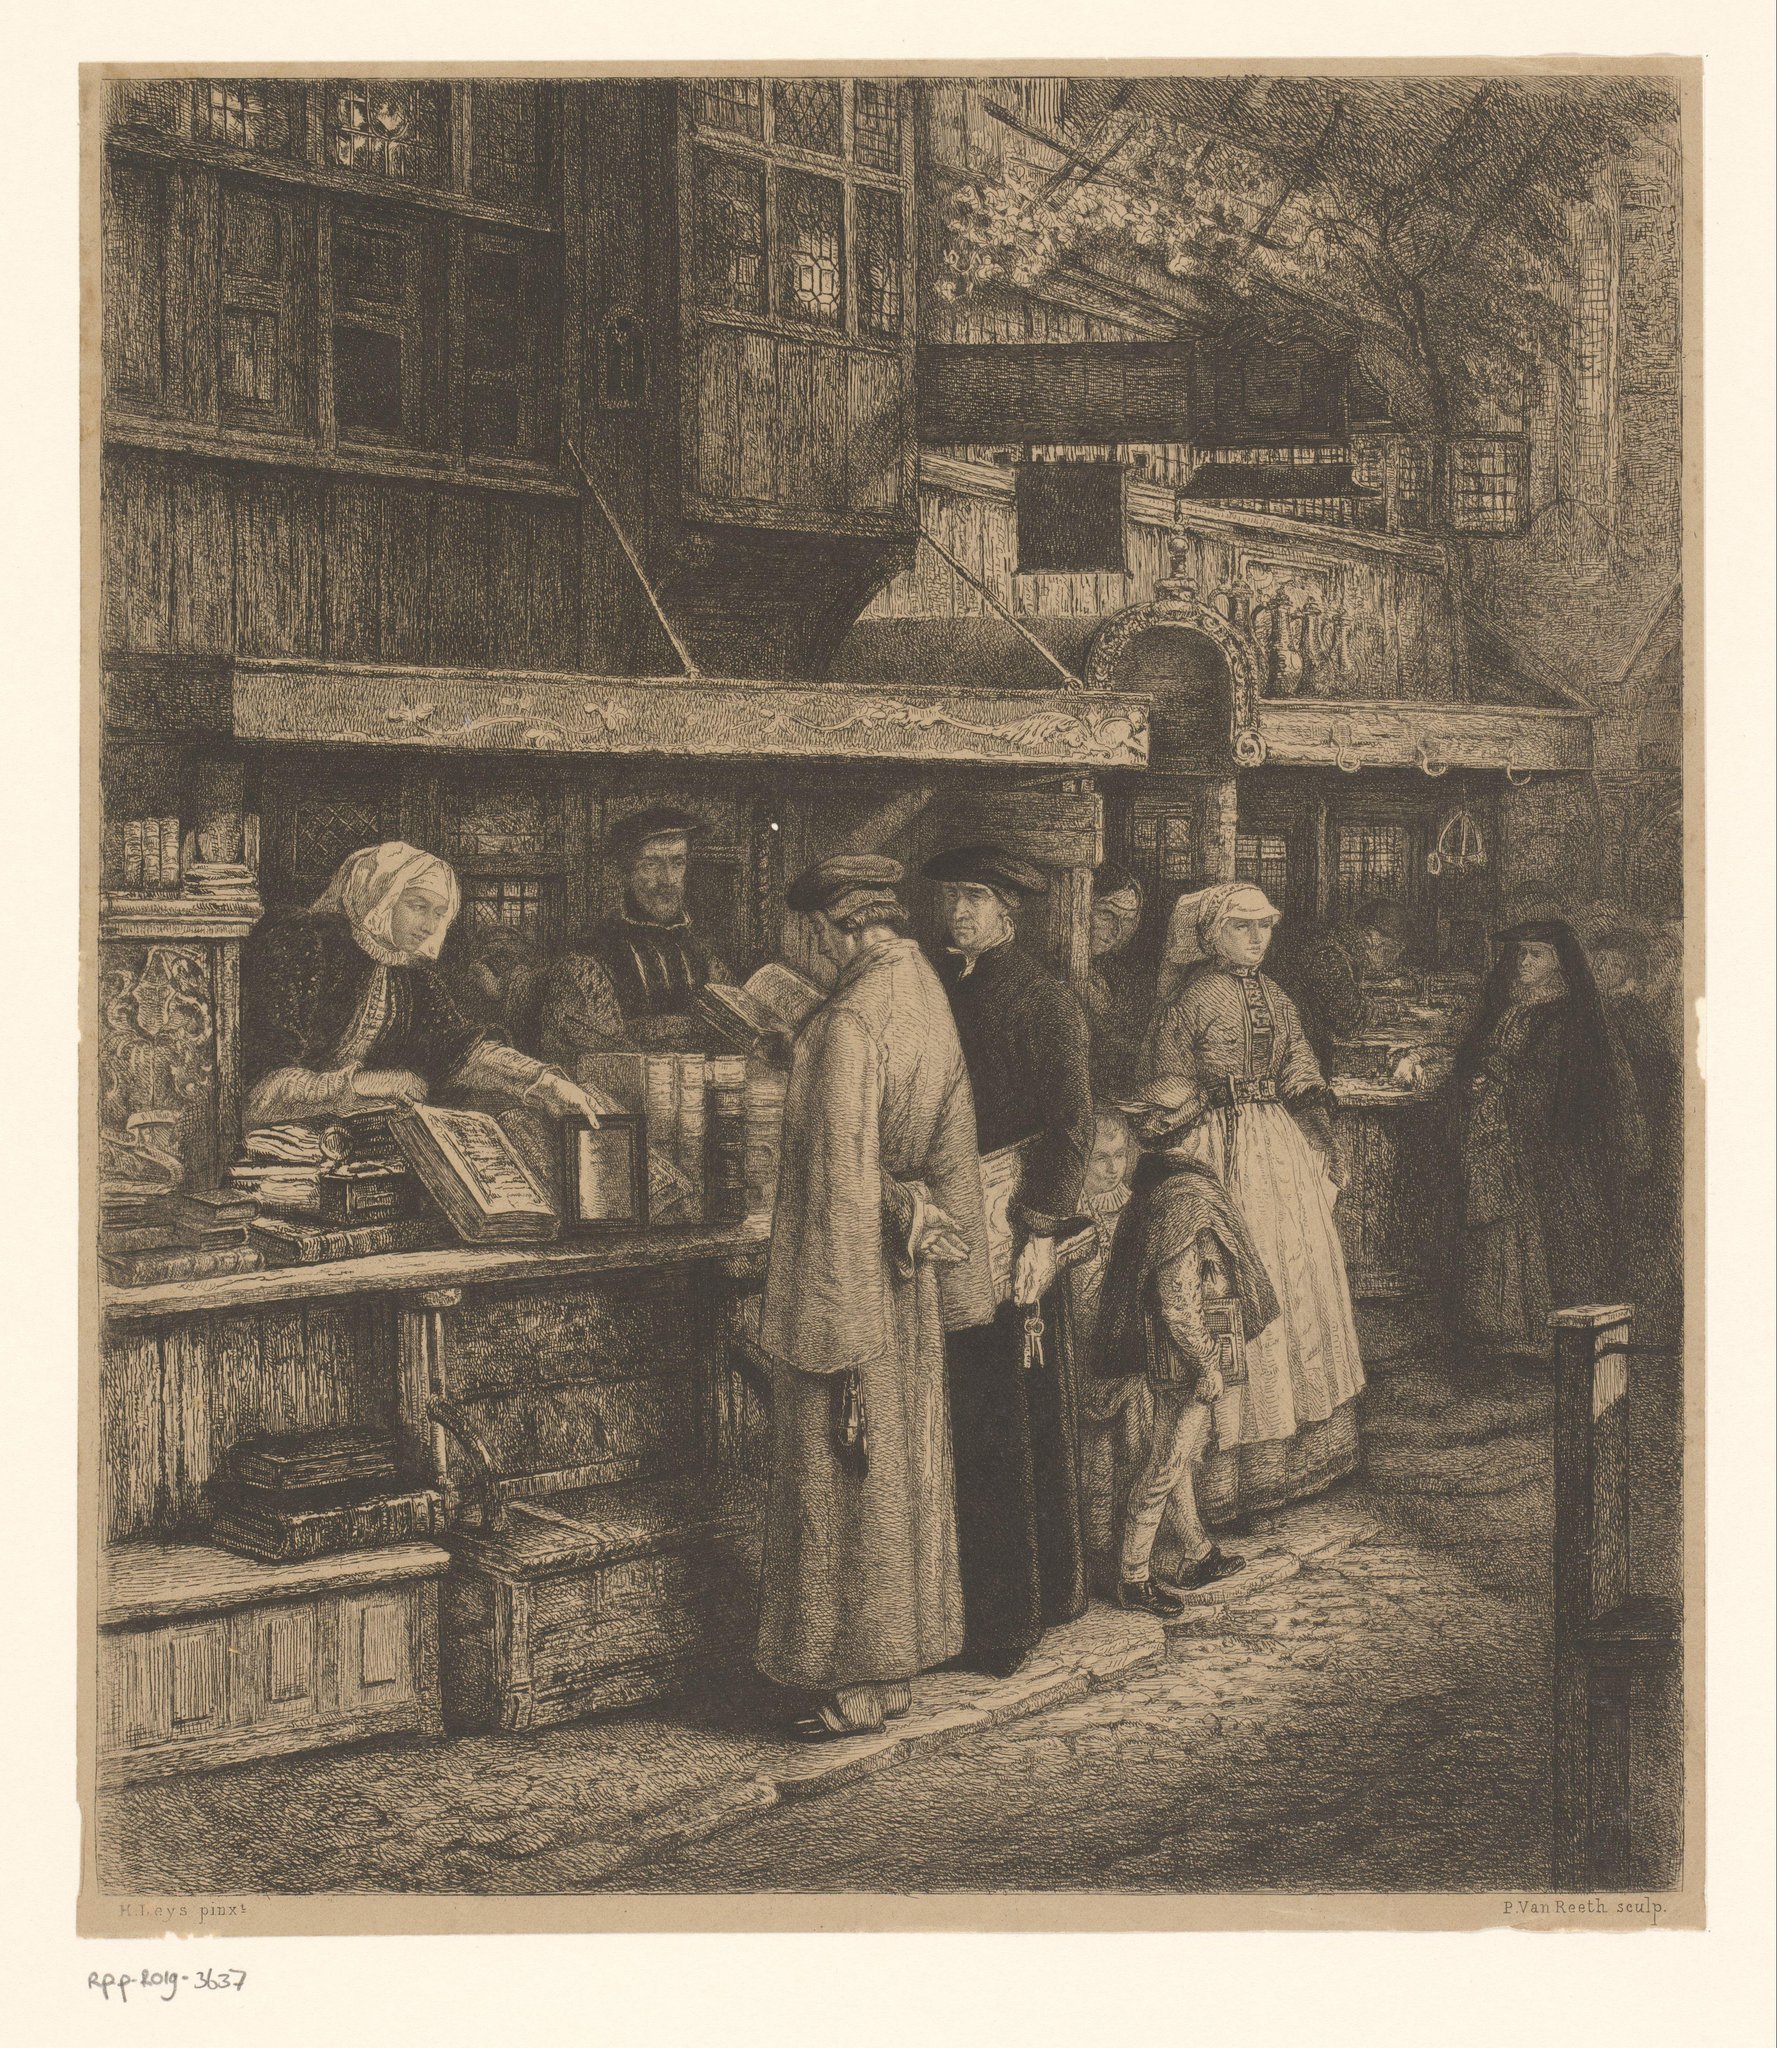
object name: print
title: Gezicht op de boekwinkel van Jacob van Liesvelt te Antwerpen in de zestiende-eeuw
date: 1832-1866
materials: paper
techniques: etching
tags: printer, house combined with shop, street, book-shop, bookseller, antwerp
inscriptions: collector's mark: Lugt 2228